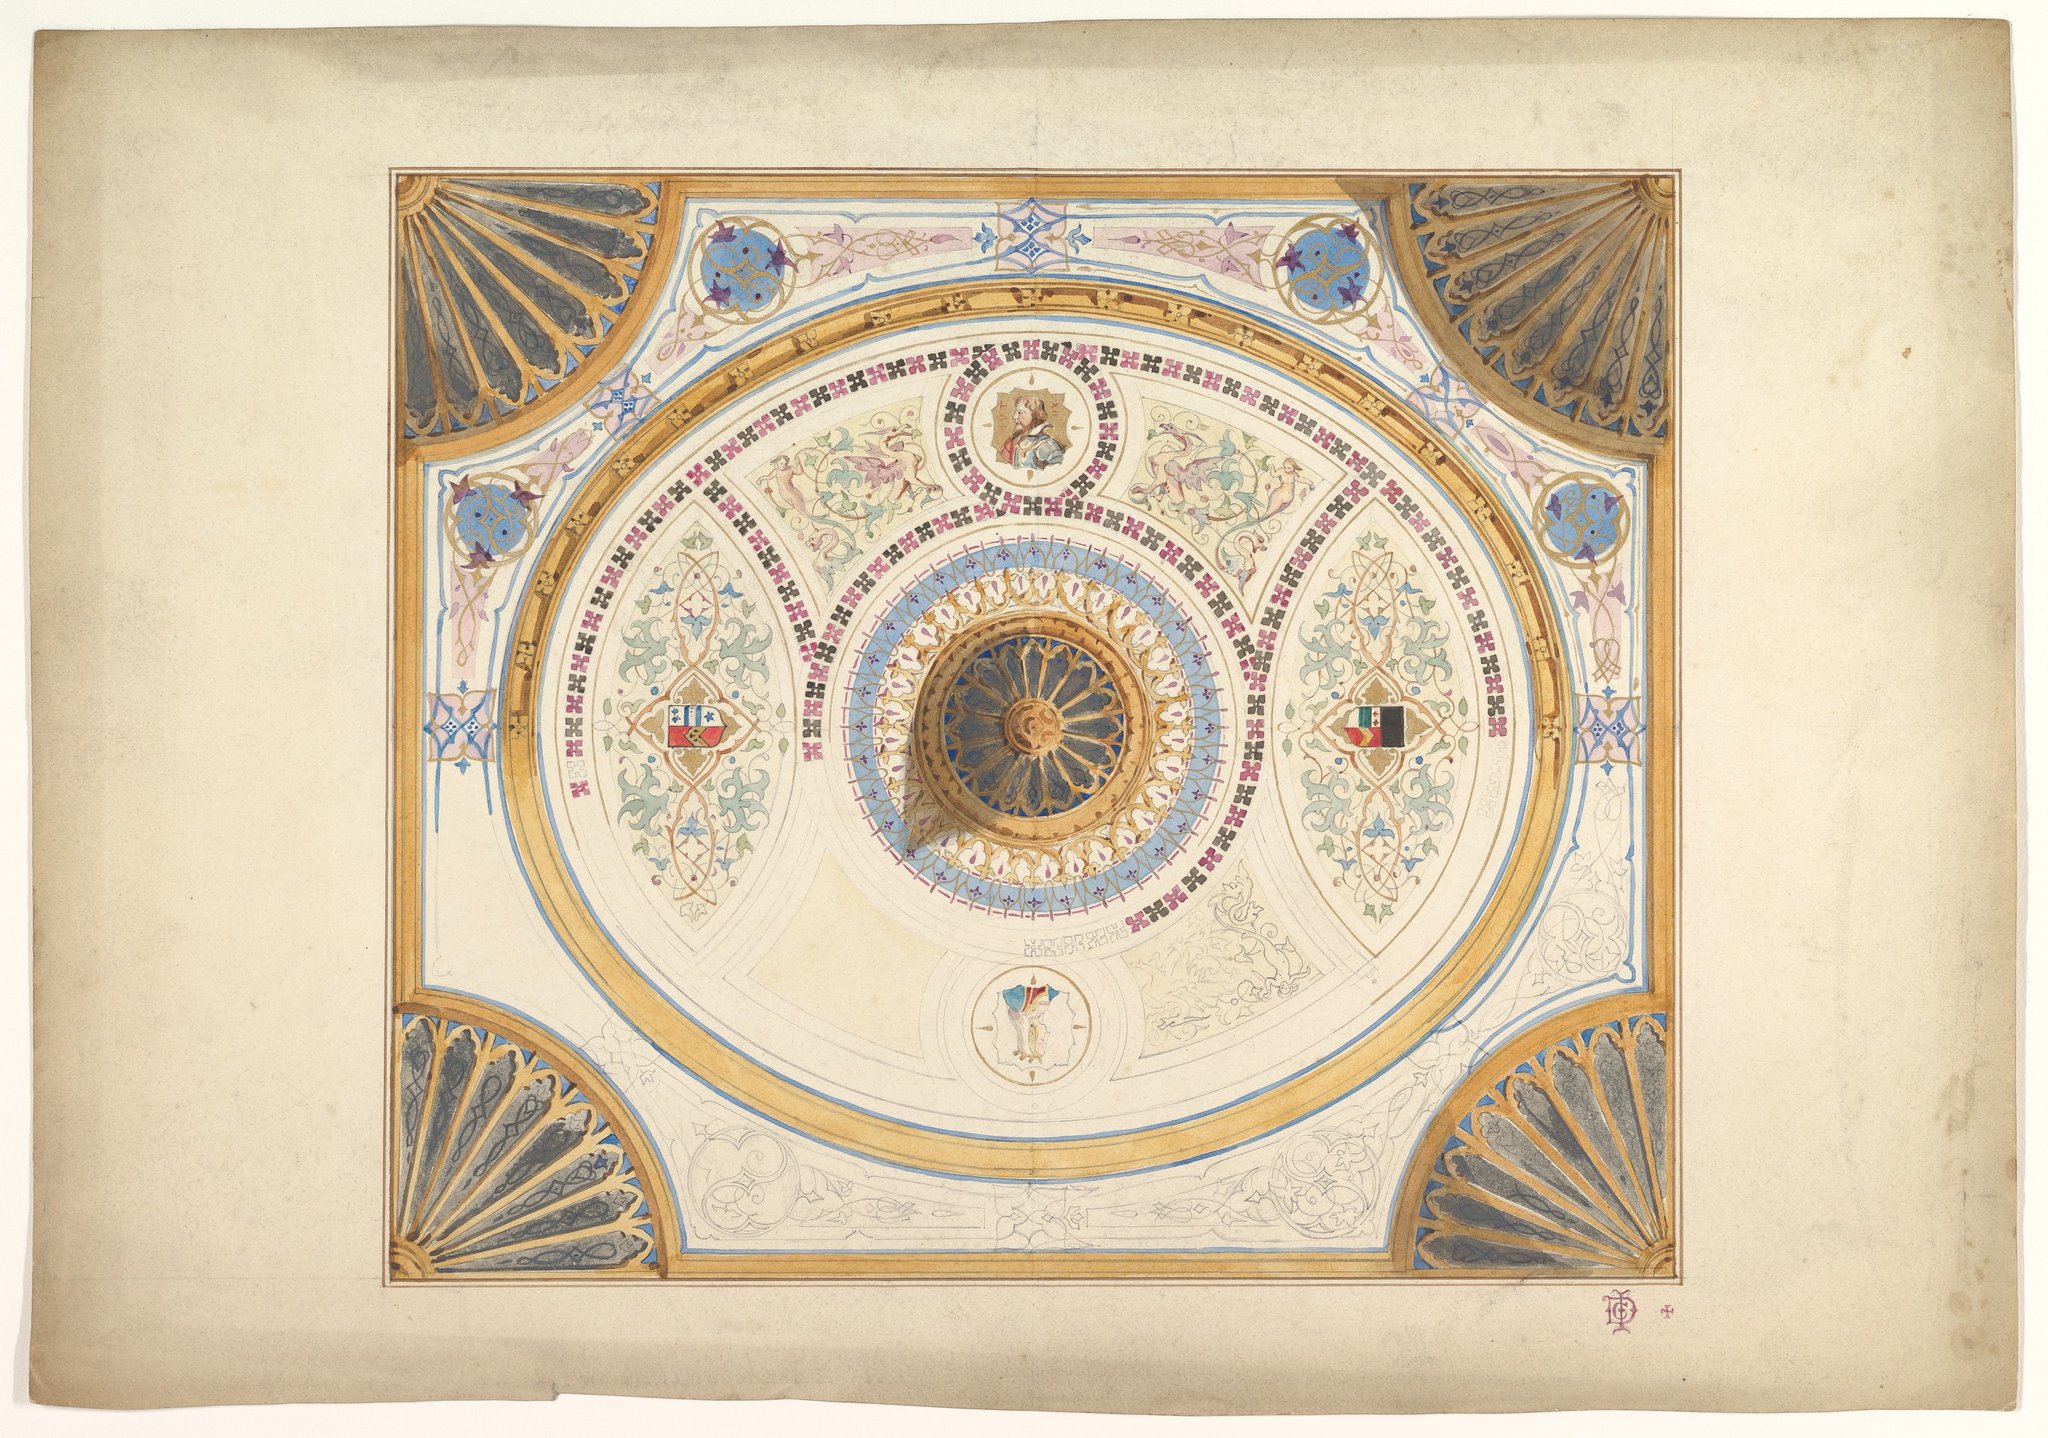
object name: drawing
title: Design for Ceiling with Two Portraits and Fan Supports at Corners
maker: john gregory crace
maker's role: artist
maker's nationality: british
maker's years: 1809-1889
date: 1801-1900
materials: gilt, graphite, watercolor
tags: men,profiles,coat of arms